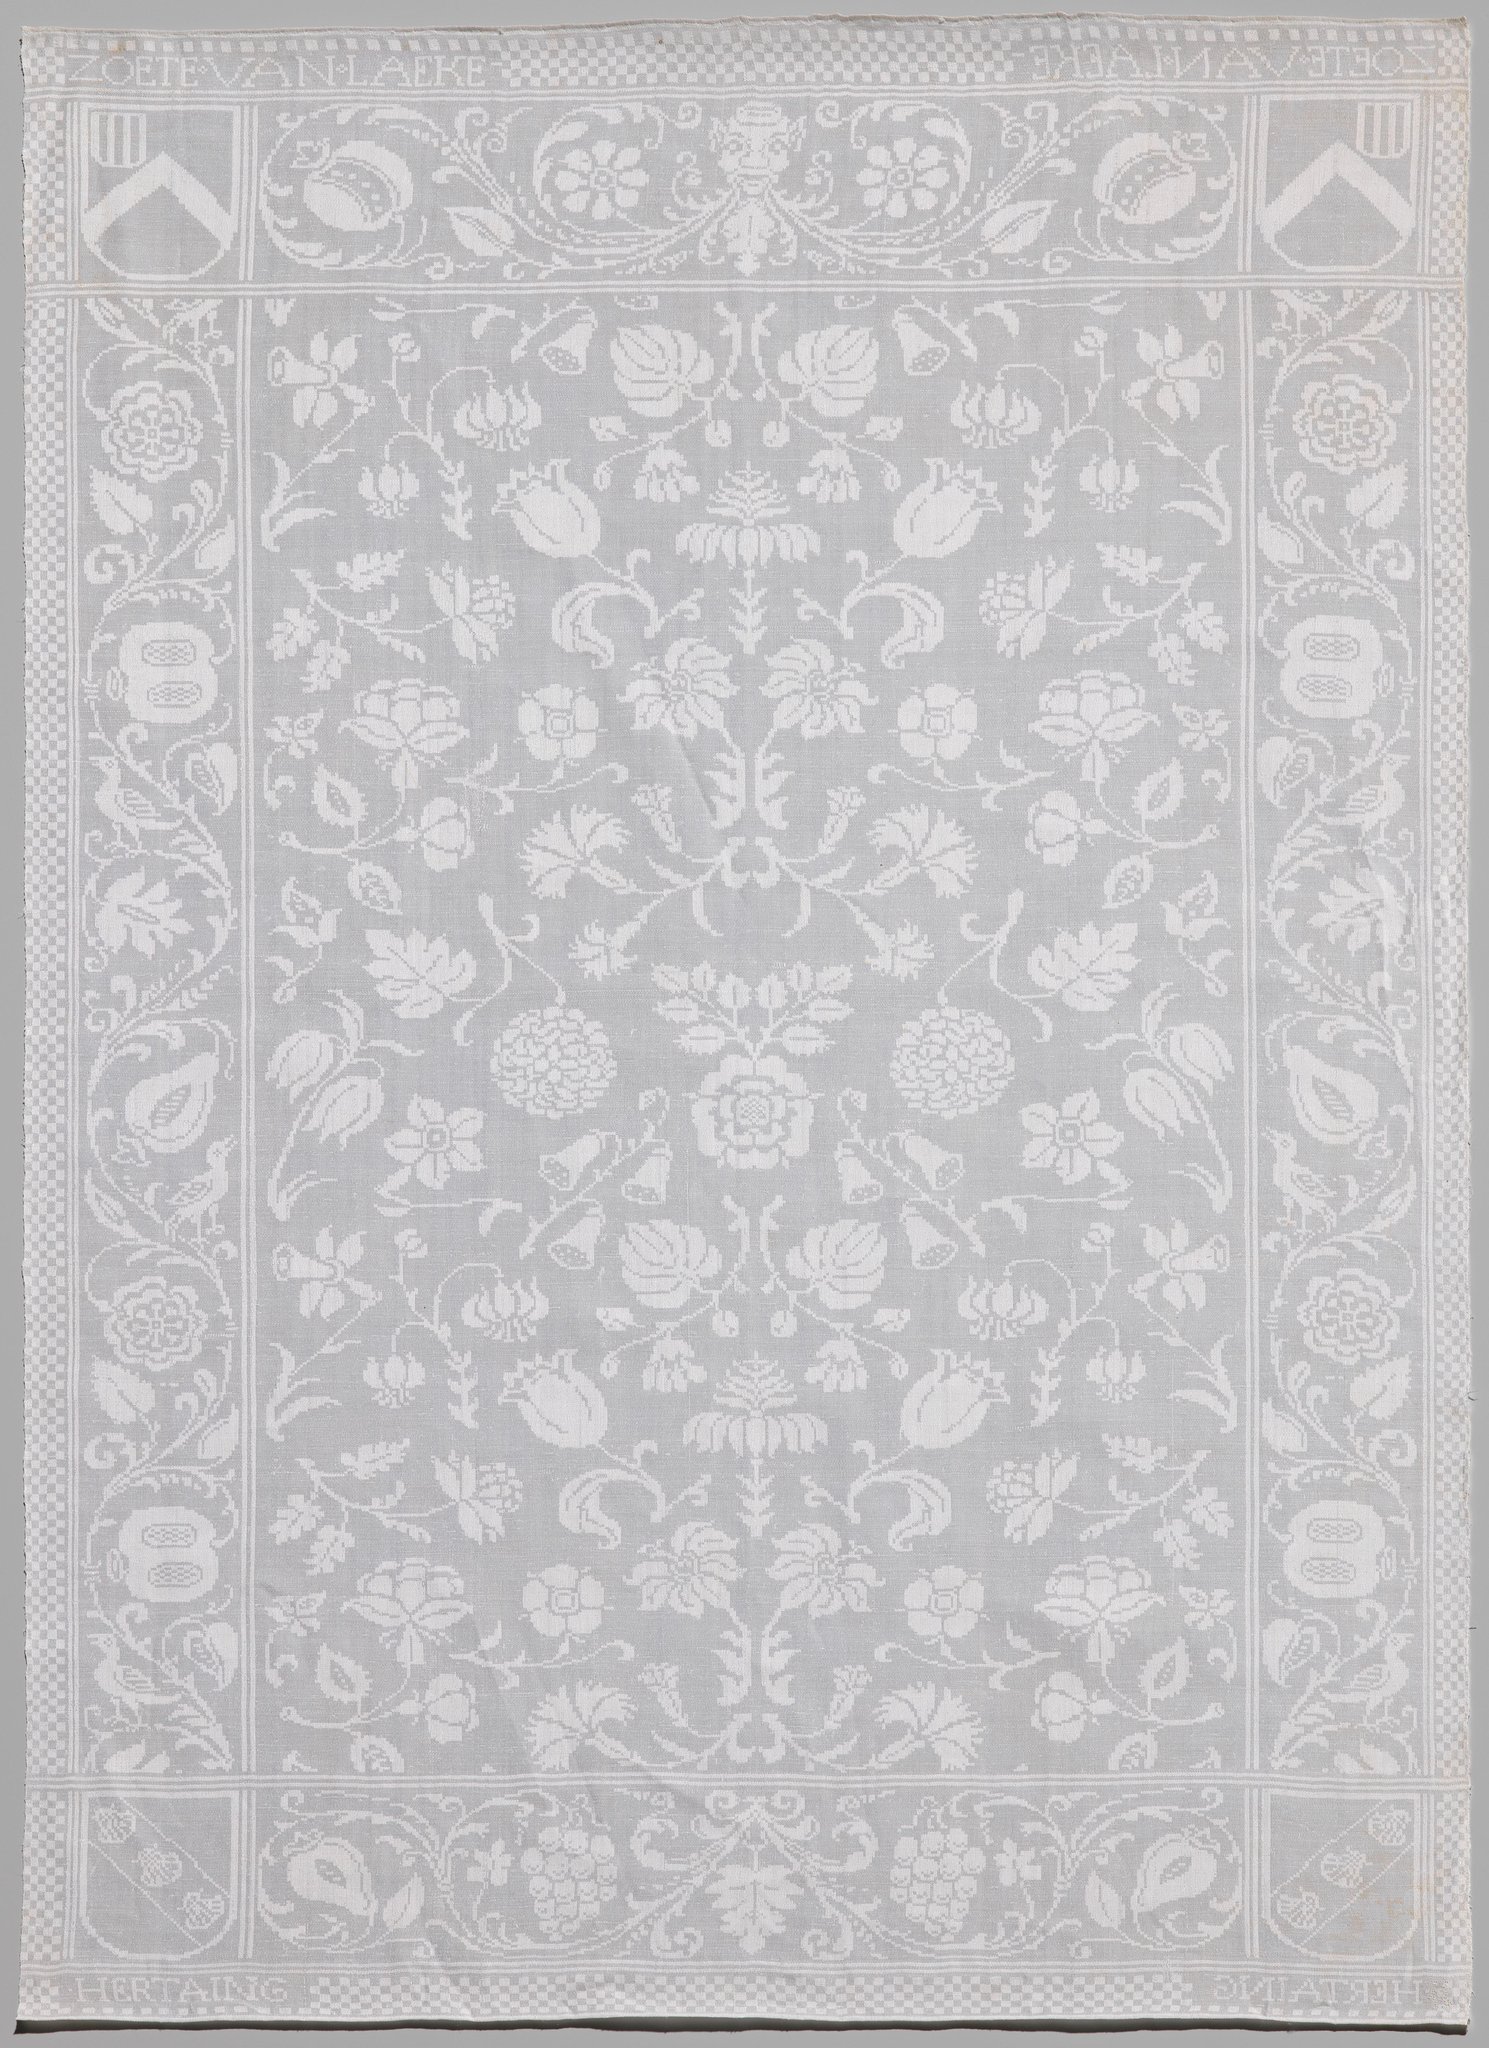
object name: napkin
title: Servet van wit linnen met patroon van gestrooide bloemen met wapen- en naaminwevingen ZOETE VAN LAEKE en HERTAING.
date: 1603-1627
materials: linen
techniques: damask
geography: northern netherlands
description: Witlinnen damasten servet met een patroon van gestrooide bloemen met de wapen- en naaminwevingen "ZOETE VAN LAEKE" en "HERTAIGN", gemerkt GL 22.